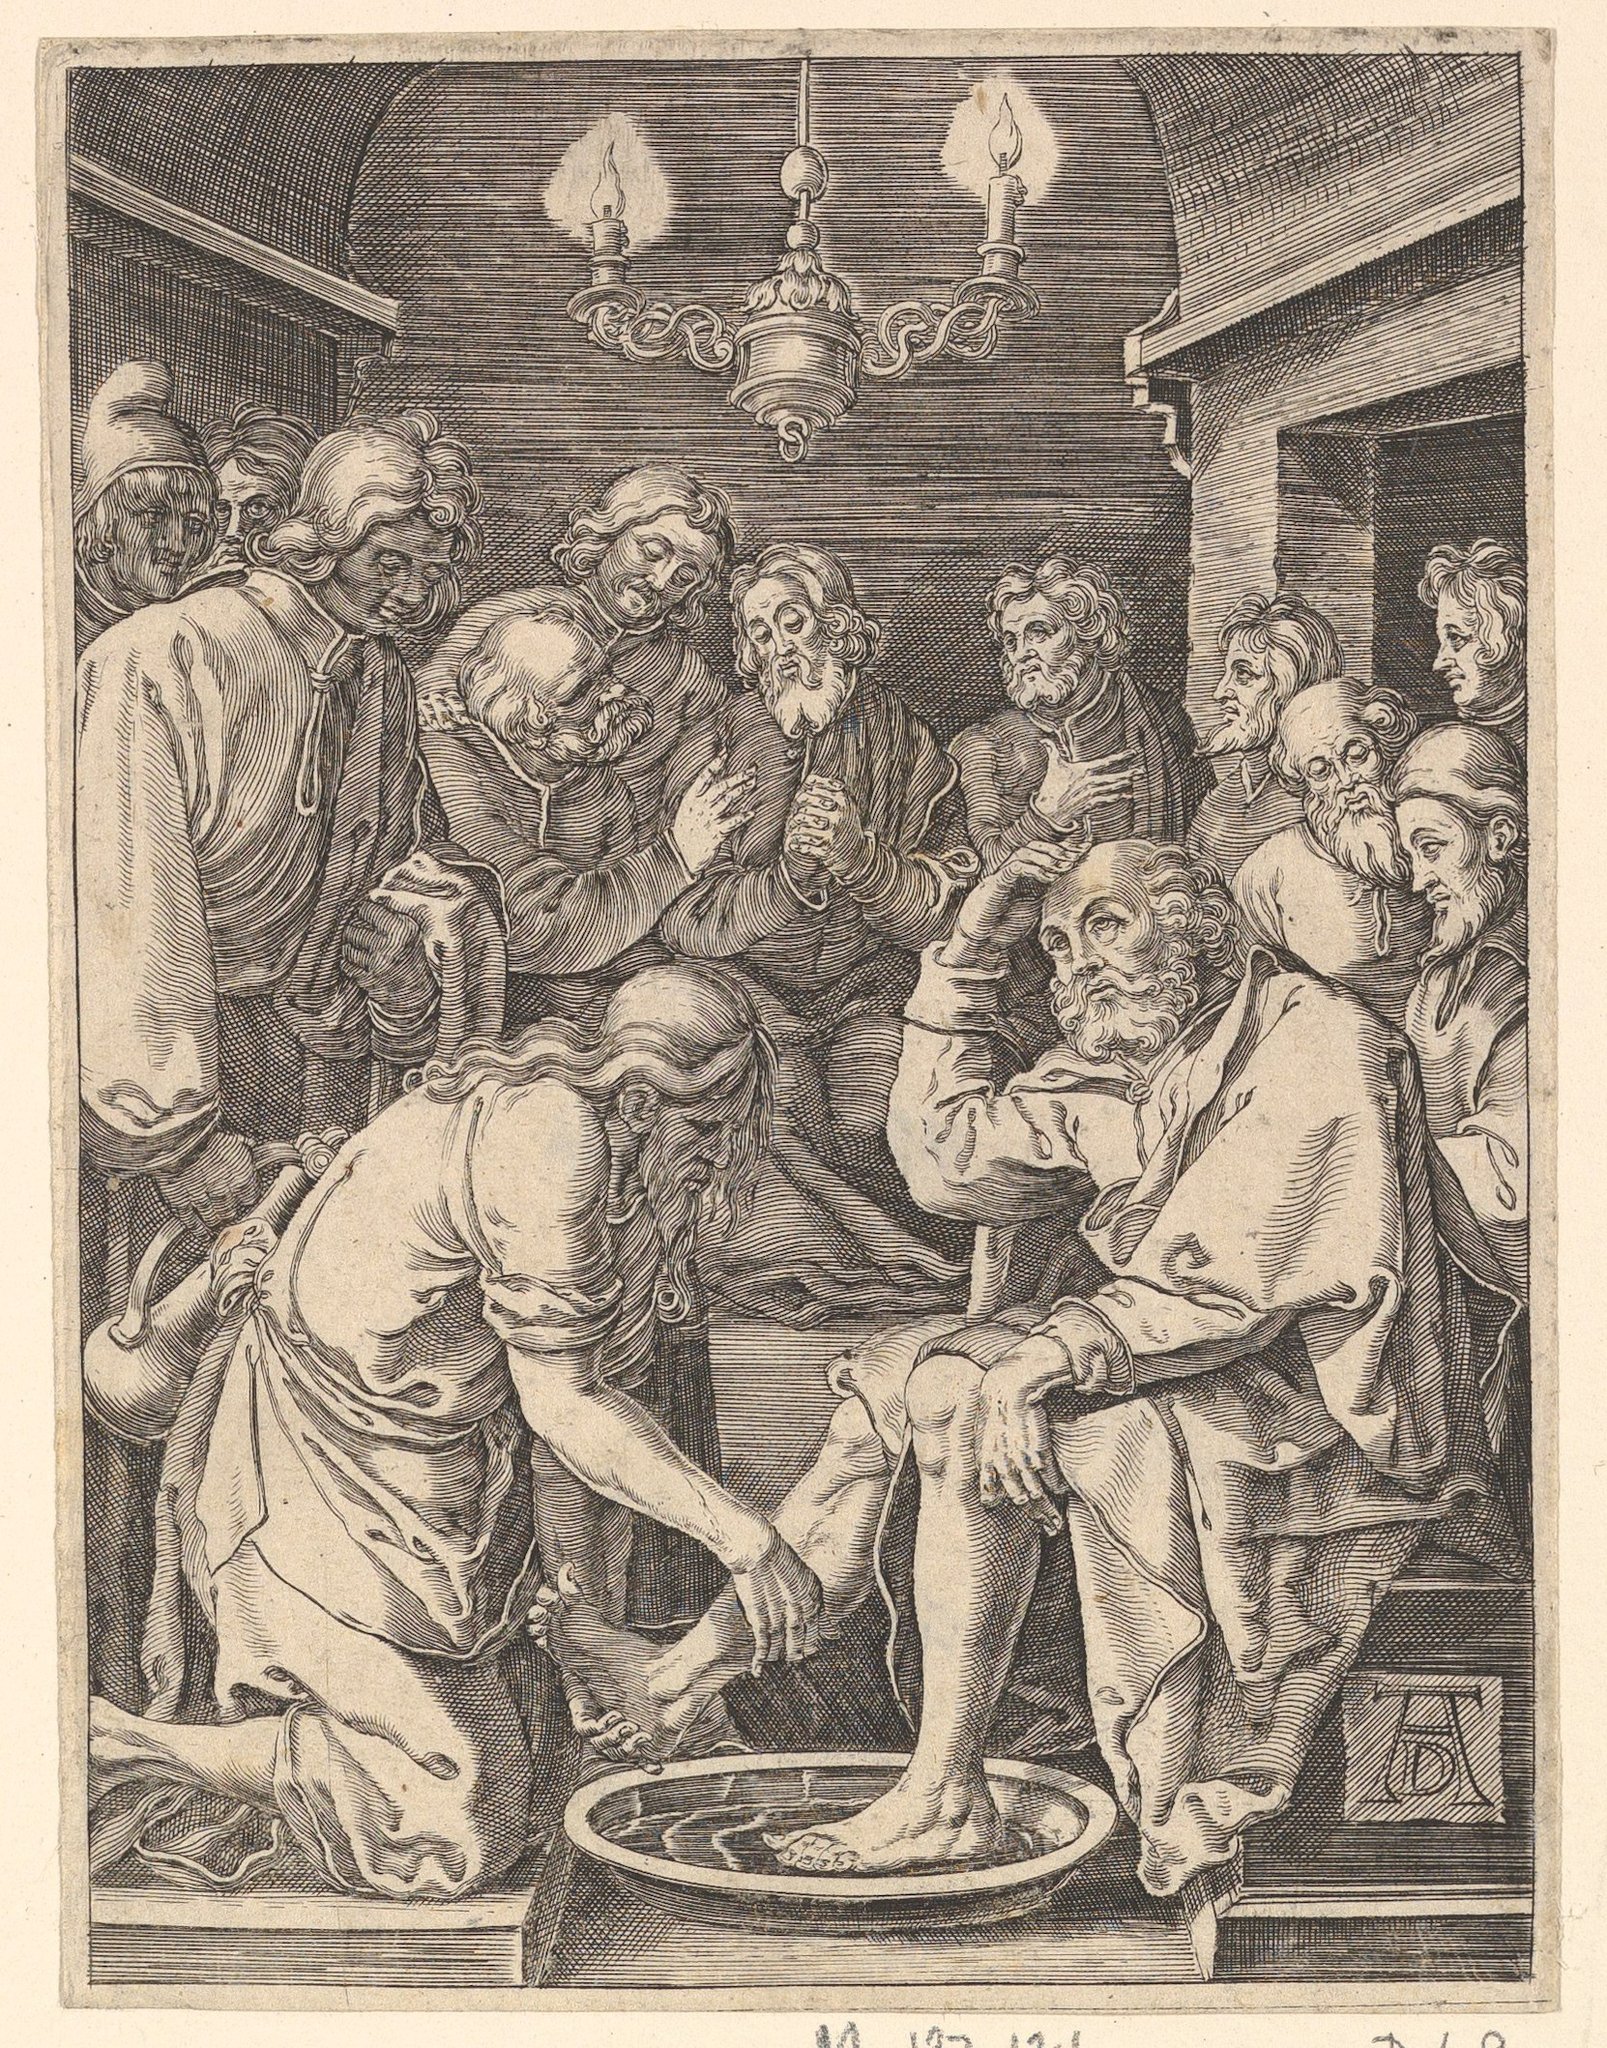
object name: print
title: Engraved copies of The Little Passion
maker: albrecht dürer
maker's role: artist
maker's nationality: german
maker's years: 1471-1528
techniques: engraving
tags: apostles,christ,washing